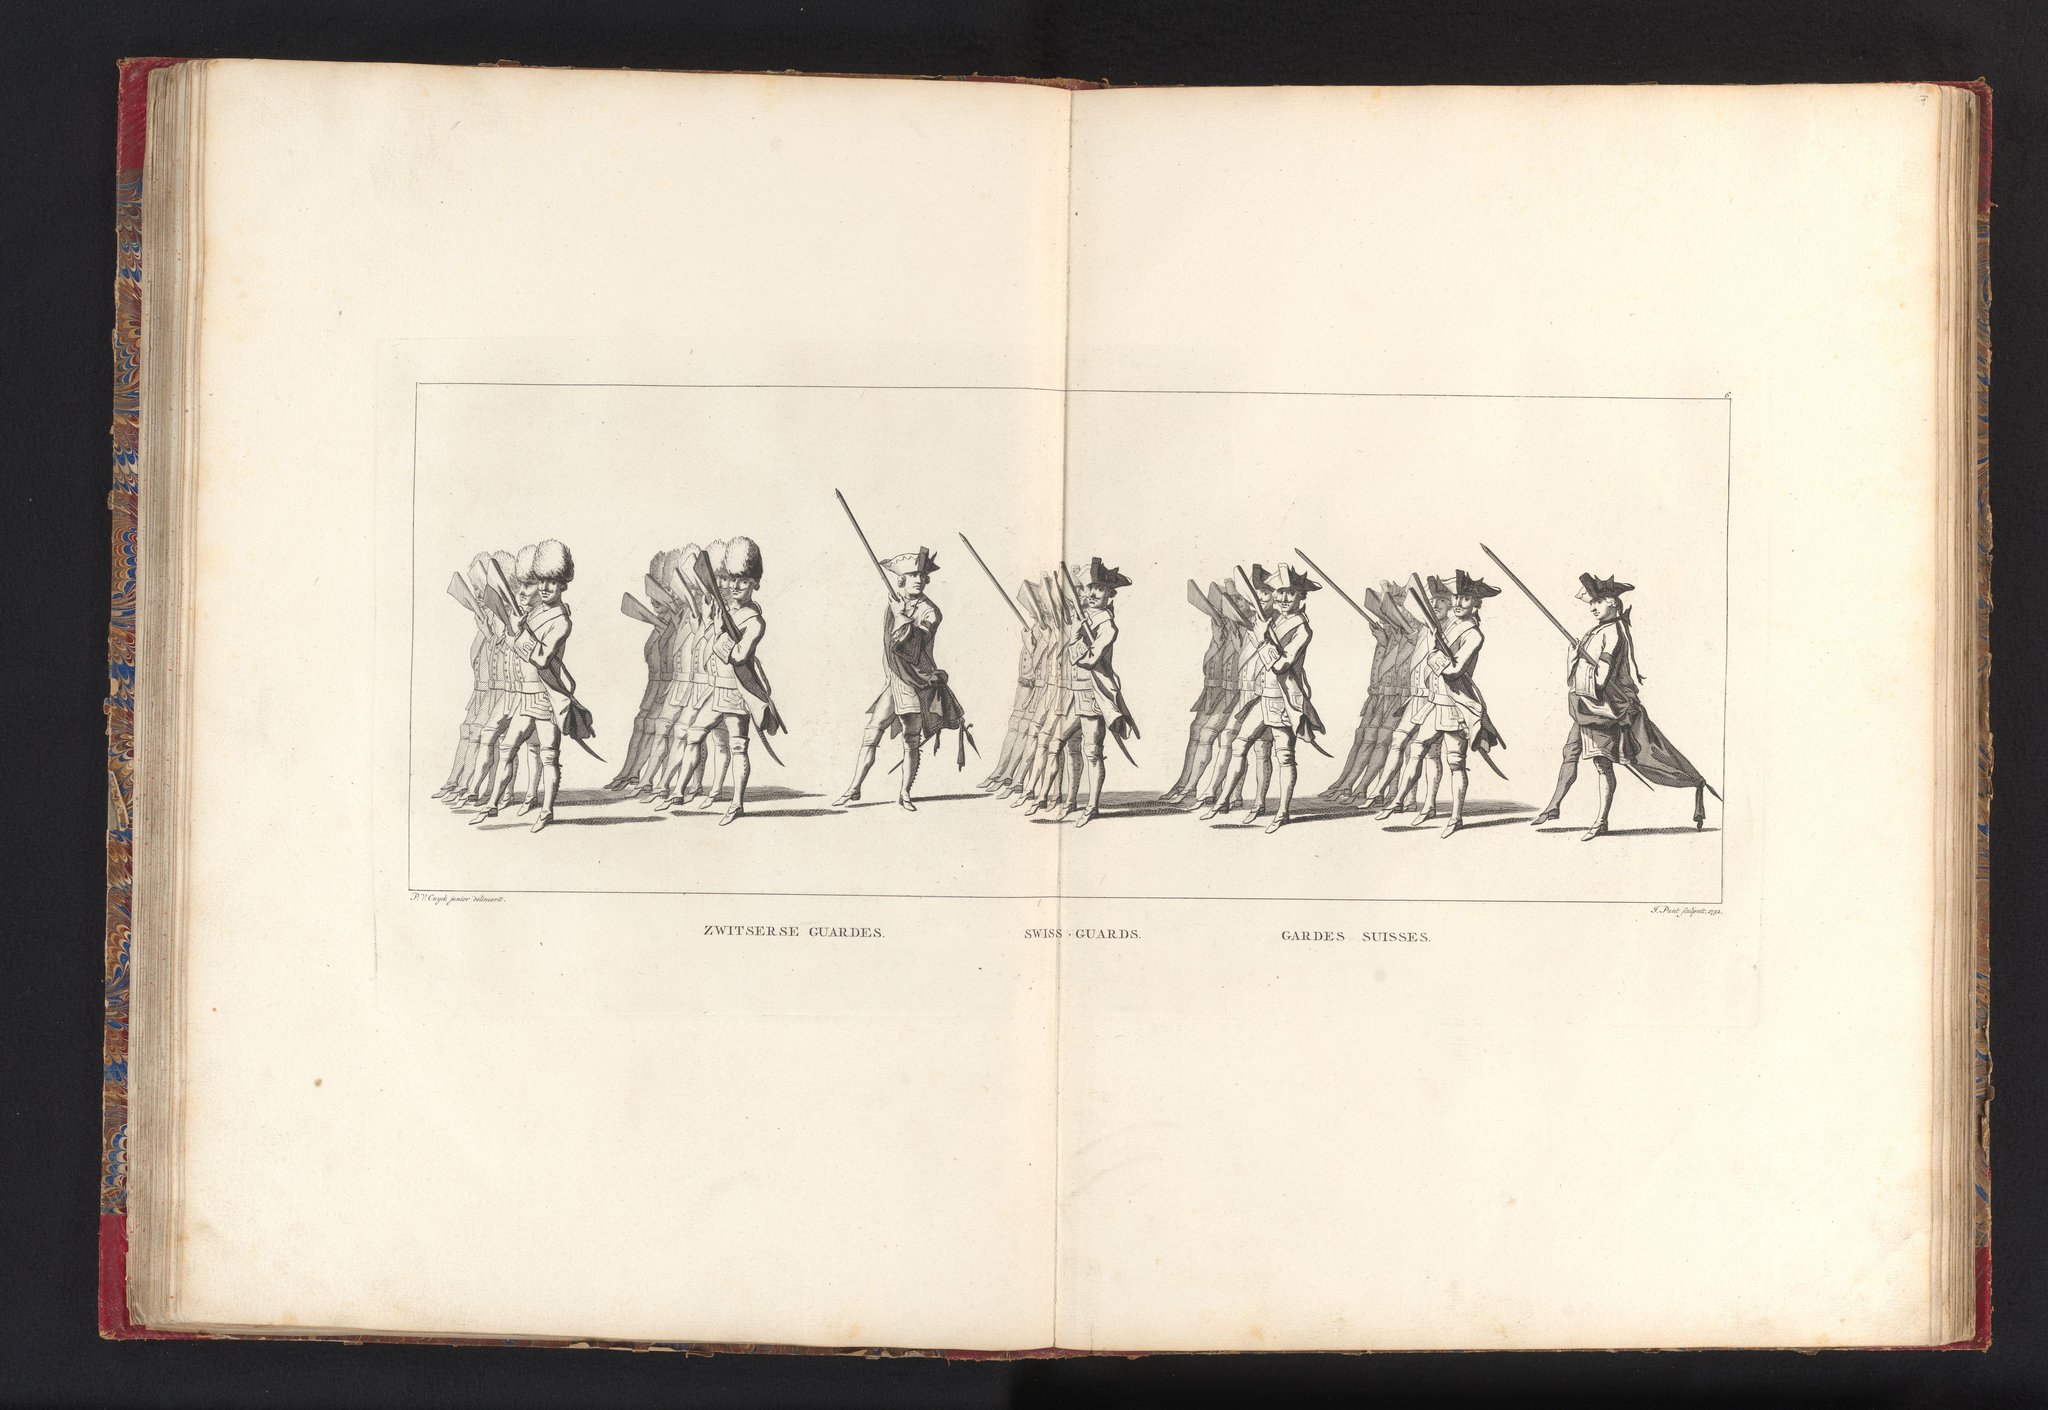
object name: album leaf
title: Lyk-staetsie van zyne doorluchtigste Hoogheid den Heere Willem Carel Hendrik Friso, Prince van Orange en Nassau (...) gehouden den IV Februari 1752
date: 1752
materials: paper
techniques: engraving, etching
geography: the hague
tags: the hague, willem iv (prins van oranje-nassau), military parade, pageant (+ infantry), cortege, funeral procession, delft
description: De Zwitserse Garde. In de marge een onderschrift in het Nederlands, Frans en Engels. De prent maakt deel uit van een album.